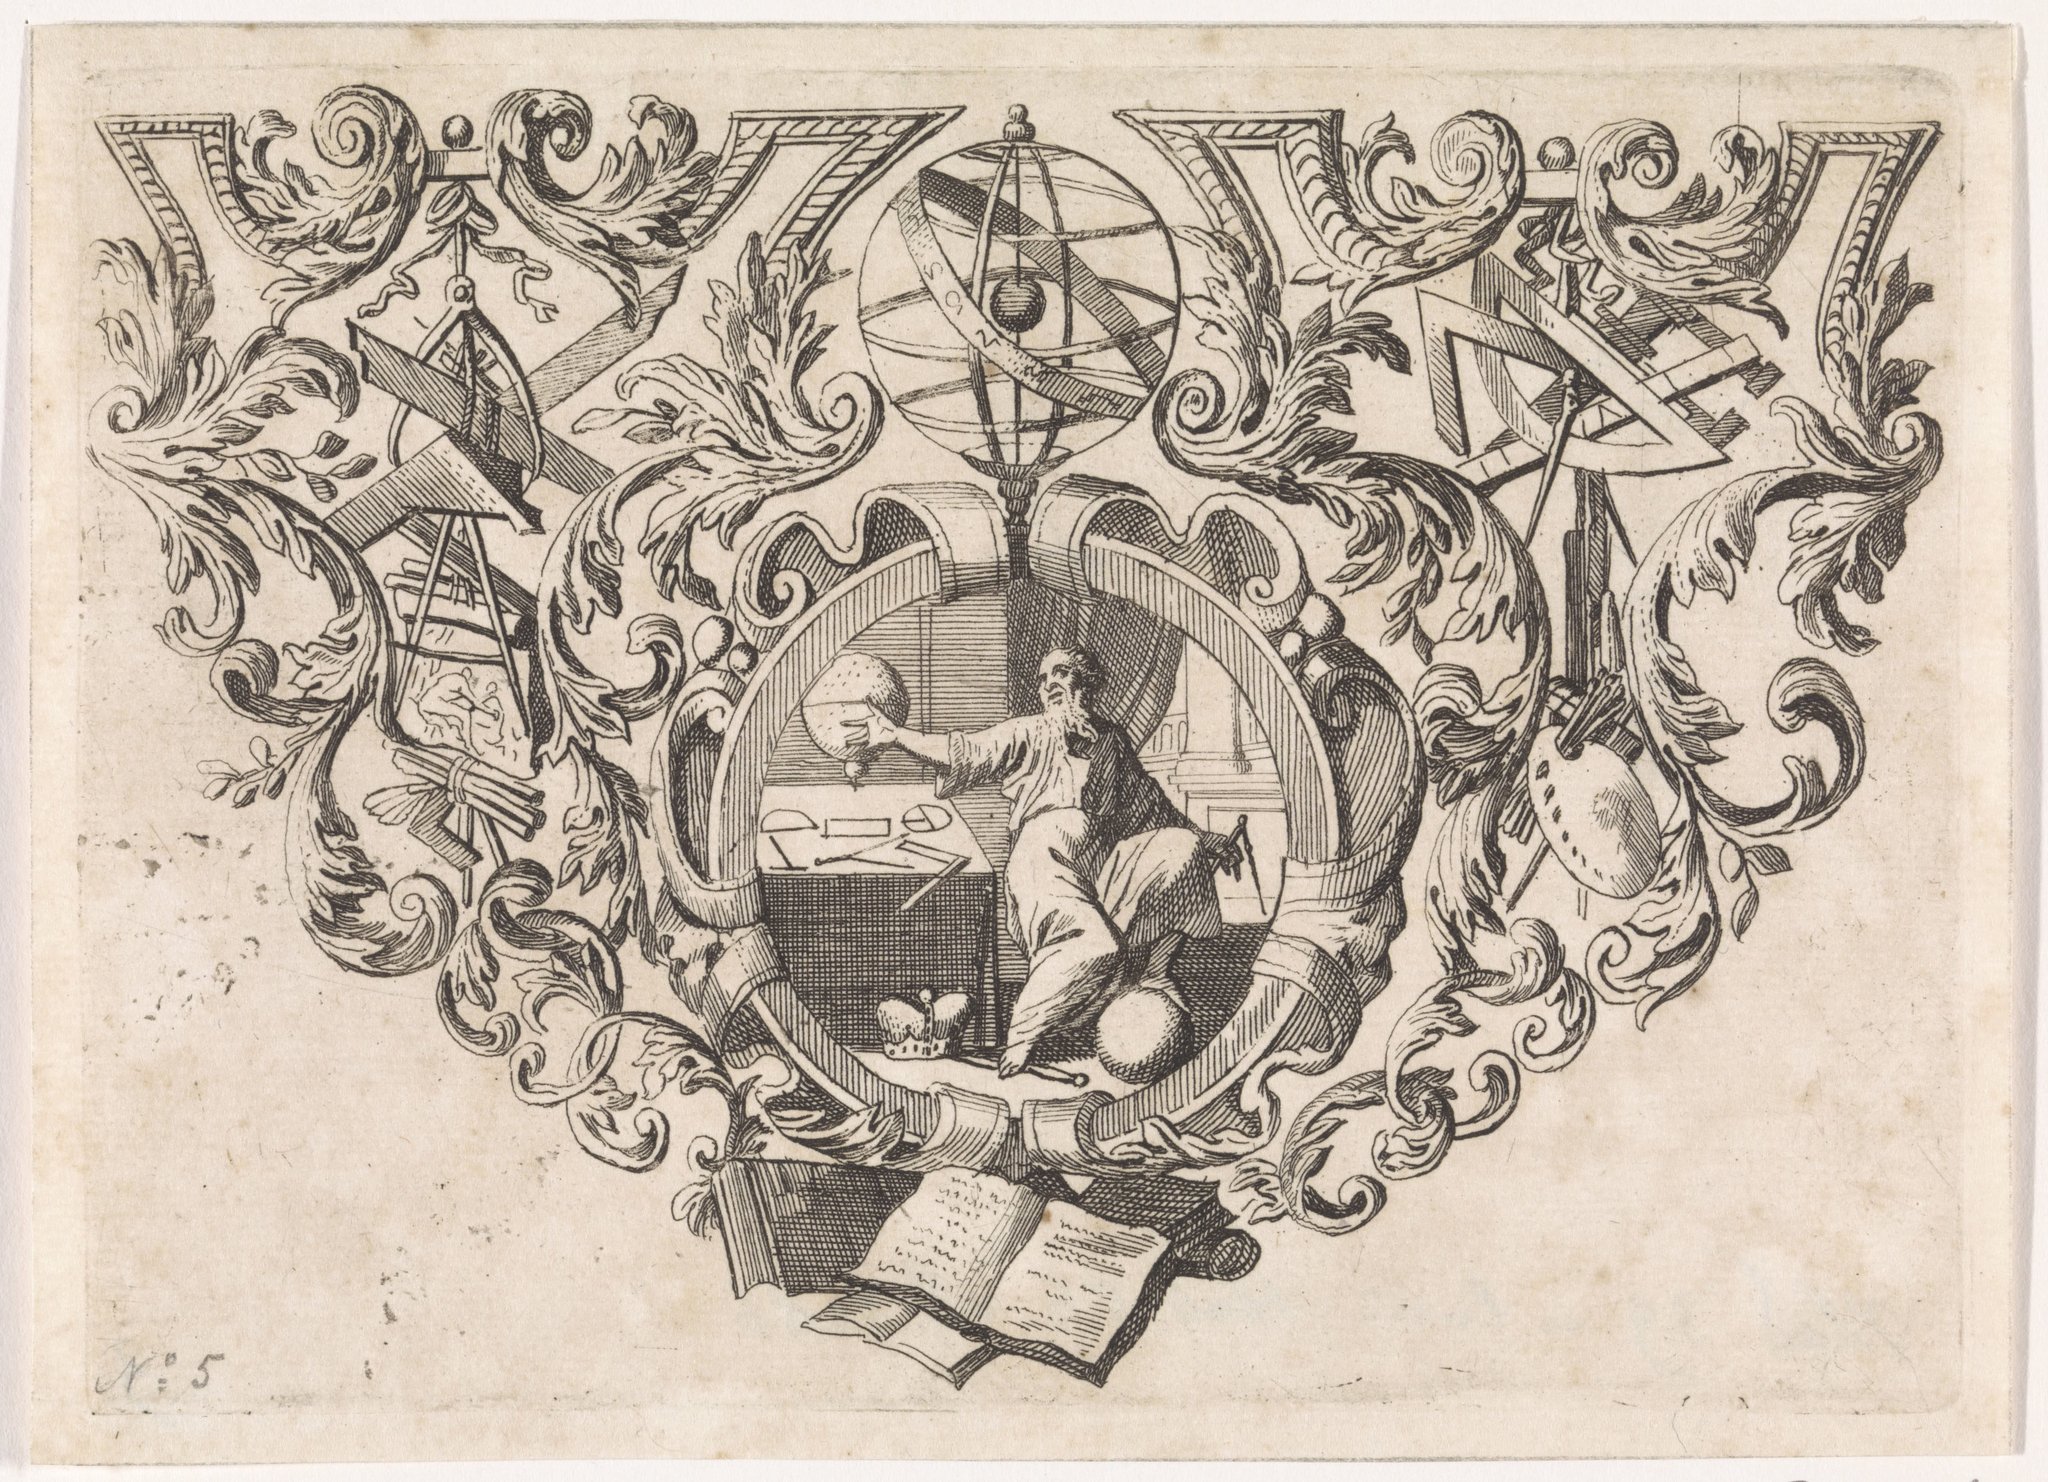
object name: book illustration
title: Geleerde met globe en meetkundige instrumenten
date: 1705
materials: paper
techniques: etching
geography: amsterdam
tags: scholar, philosopher, measuring-instruments, armillary sphere, skeleton celestial globe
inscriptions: collector's mark: Lugt 2228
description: Illustratie uit: Basnage, Jacobus. 't Groot waerelds tafereel, waar in de heilige en waereldsche geschiedenissen en veranderingen zedert de schepping des waerelds tot het uiteinde van de Openbaring van Joannes, worden afgemaalt, 3 delen. Amsterdam: Jacob Lindenberg, 1705.